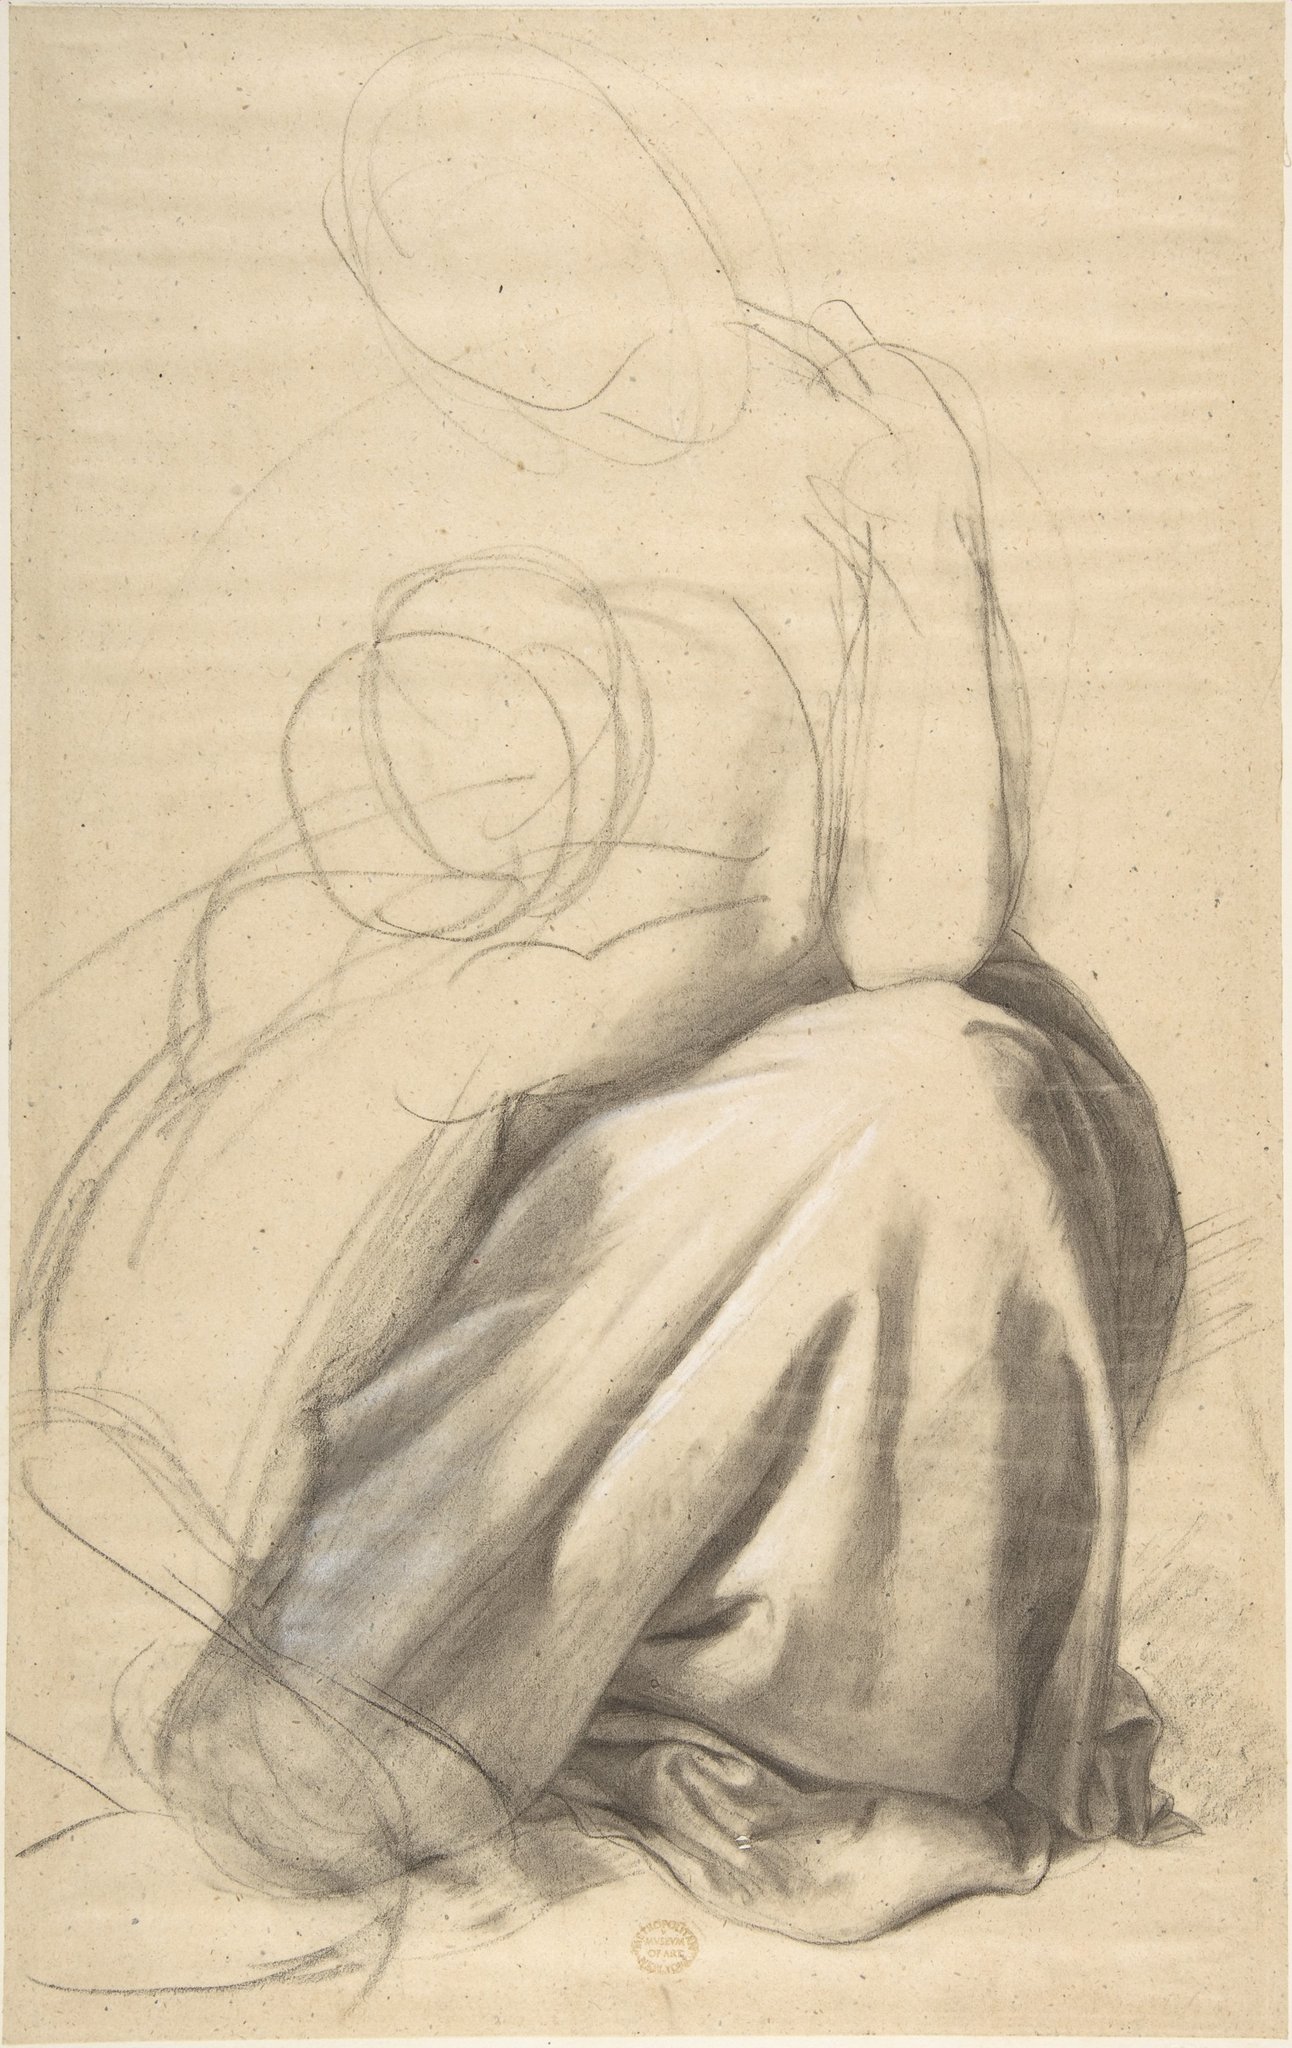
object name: drawing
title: Study of a Woman and Child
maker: romain cazes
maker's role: artist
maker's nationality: french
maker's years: 1808-1881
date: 1828-1881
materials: chalk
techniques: highlighting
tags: infants,women